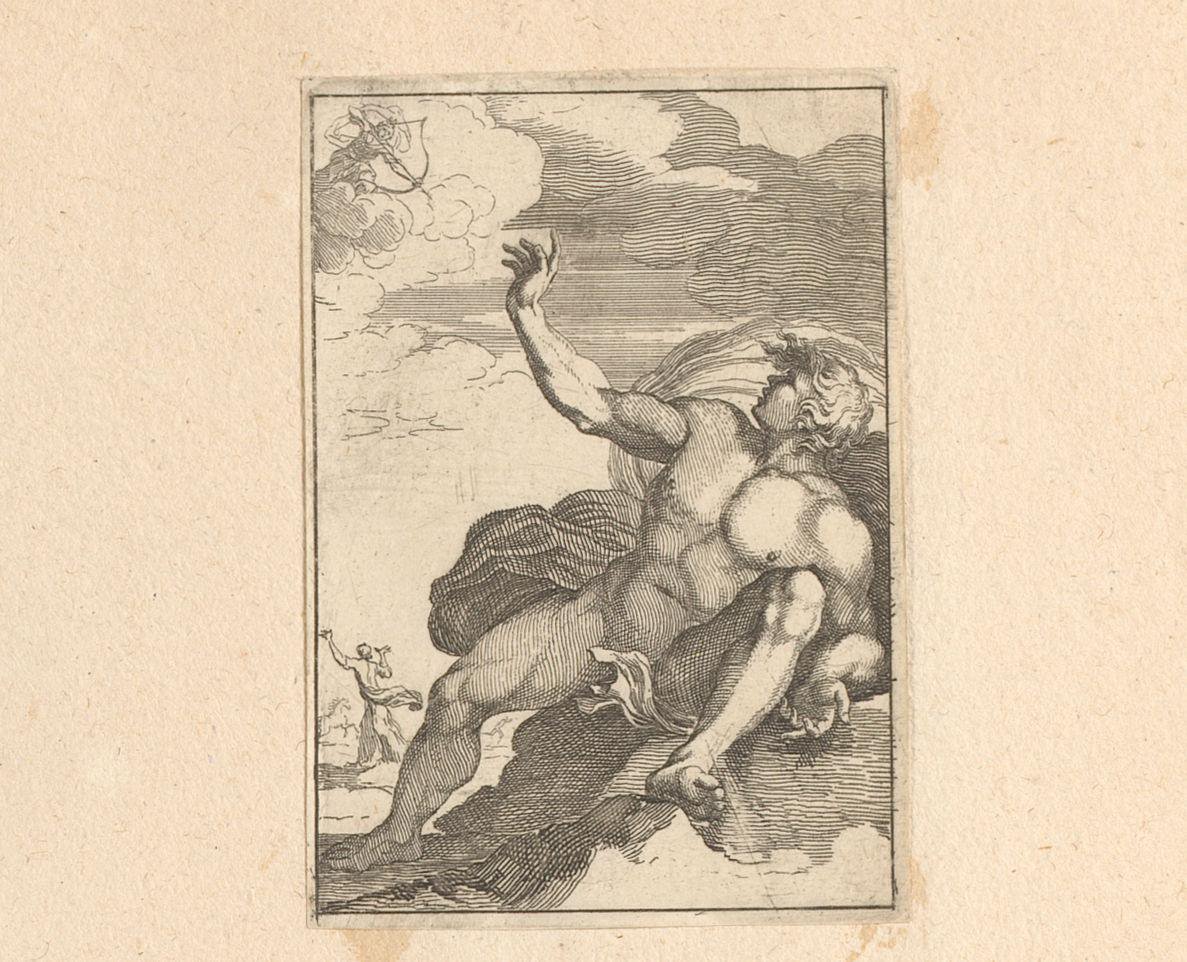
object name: album leaf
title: Zoon van Niobe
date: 1665-1673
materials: paper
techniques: etching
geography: paris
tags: model-books ~ implements of painter, apollo and diana kill niobe's children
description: Maakt deel uit van een 32-delige serie met tekenvoorbeelden van goden en helden uit de klassieke oudheid. Een eerste editie werd in 1673 uitgegeven en een tweede in 1684 door Nicolas Langlois.